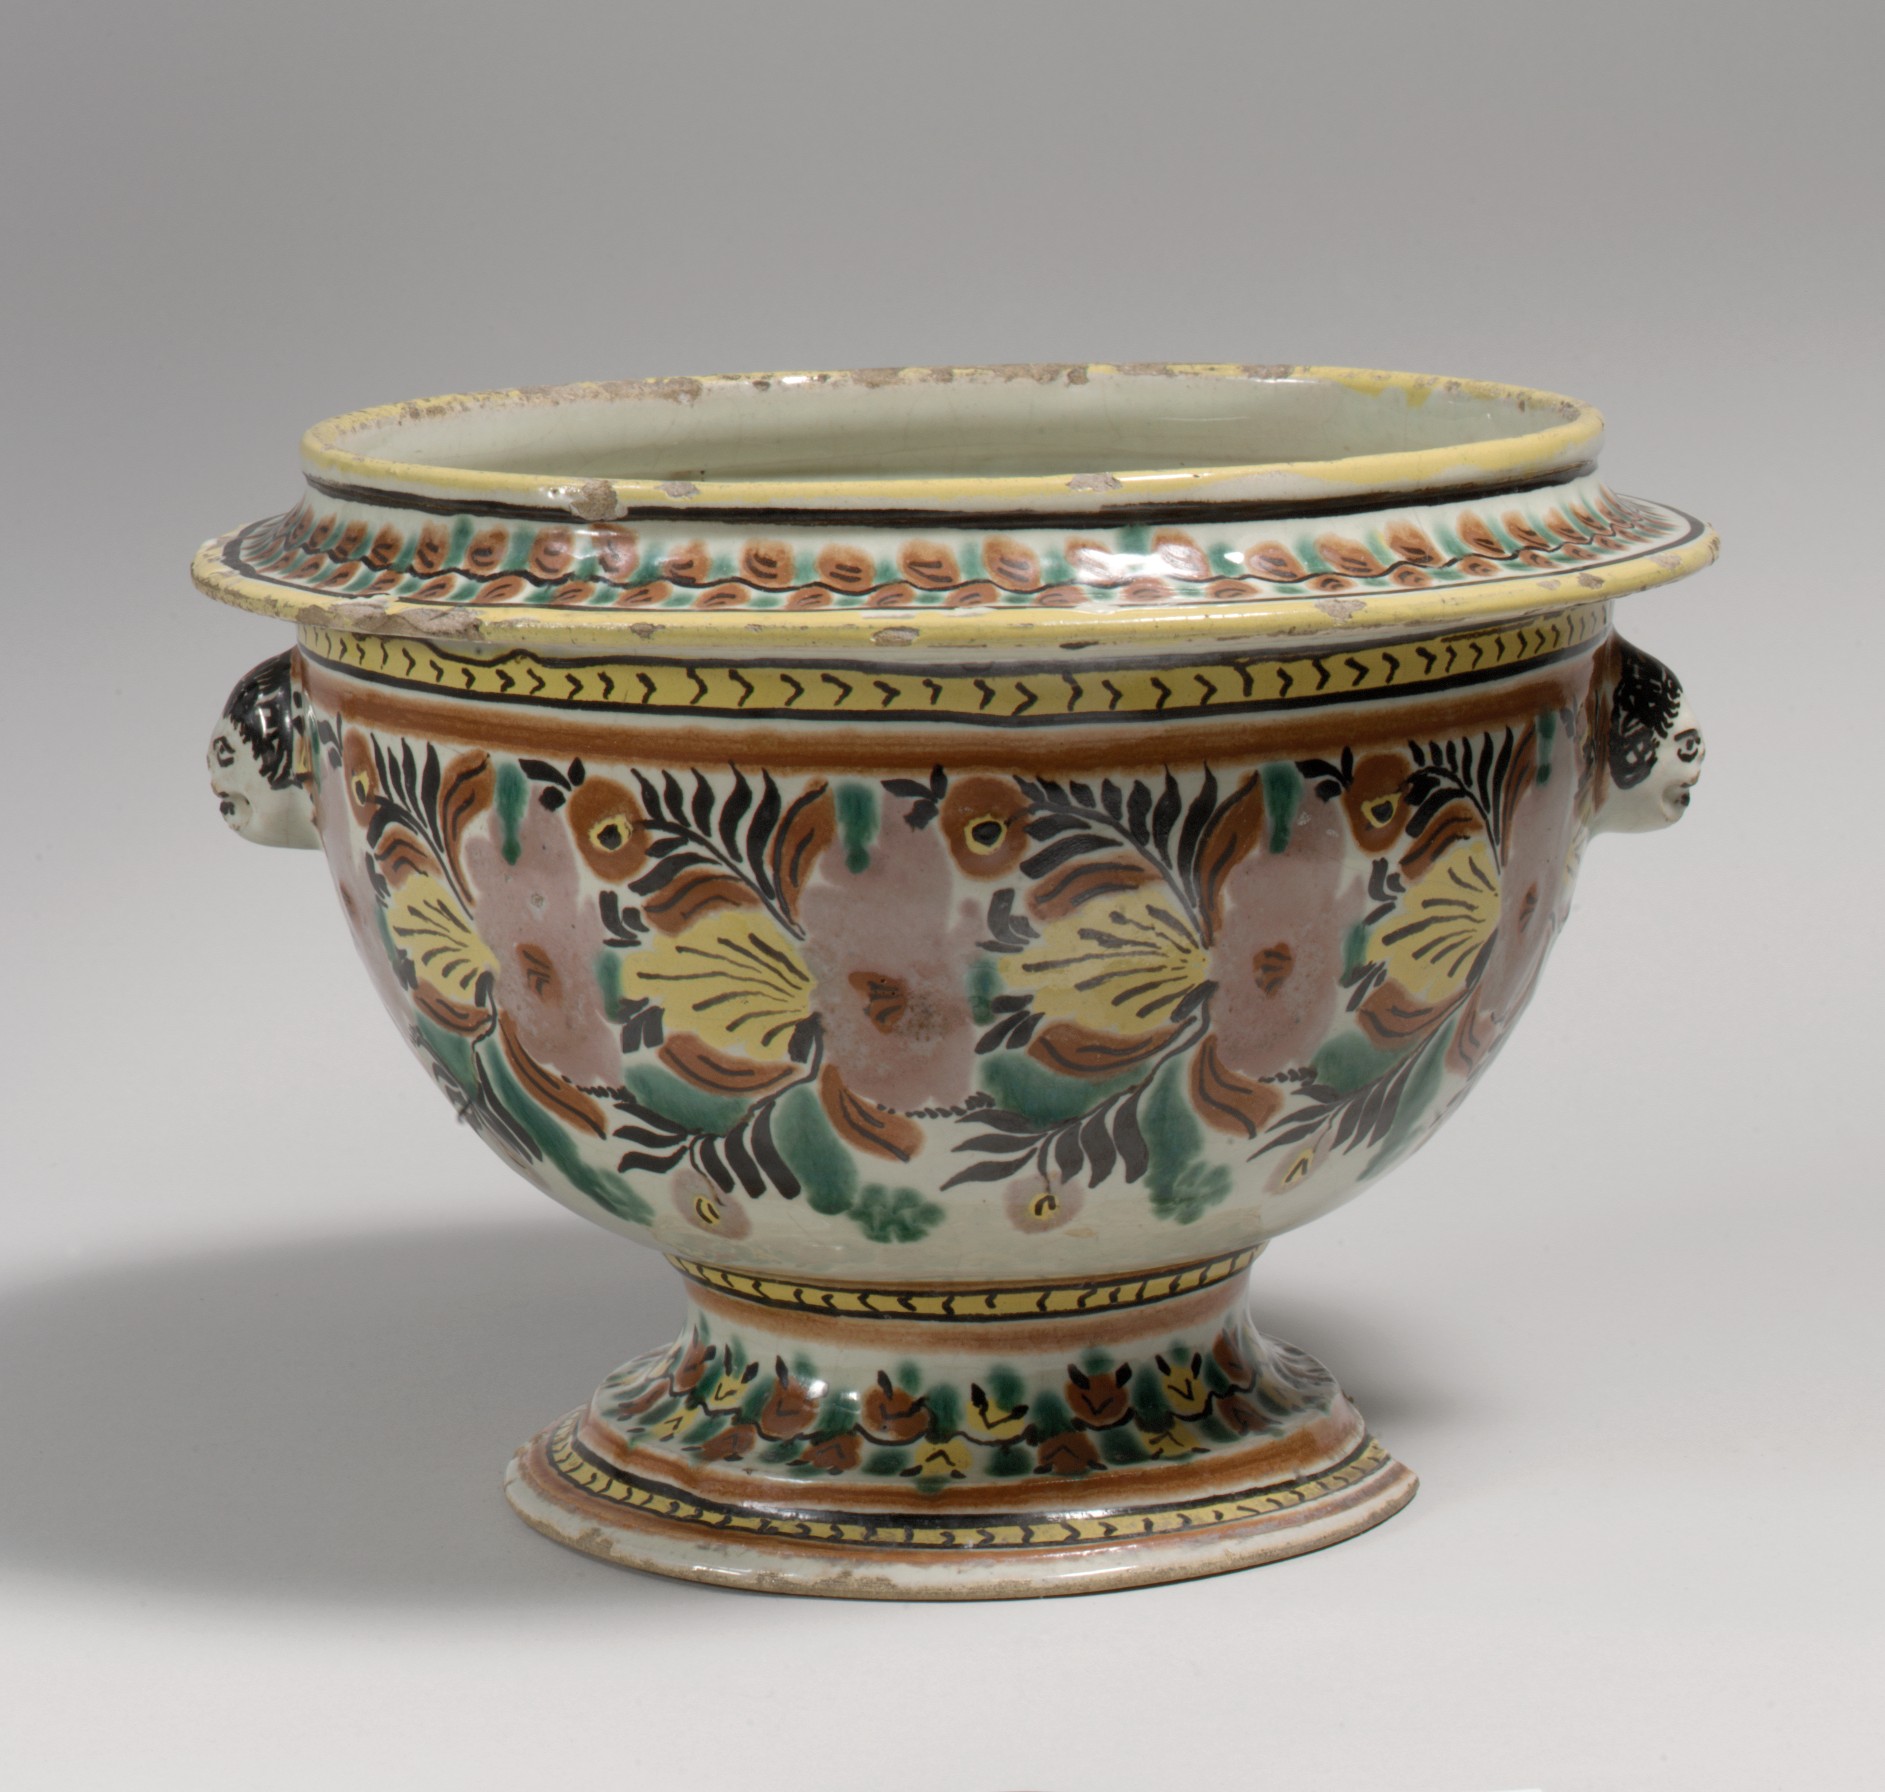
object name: bowl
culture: mexican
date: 1835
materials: earthenware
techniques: glazing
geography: mexico